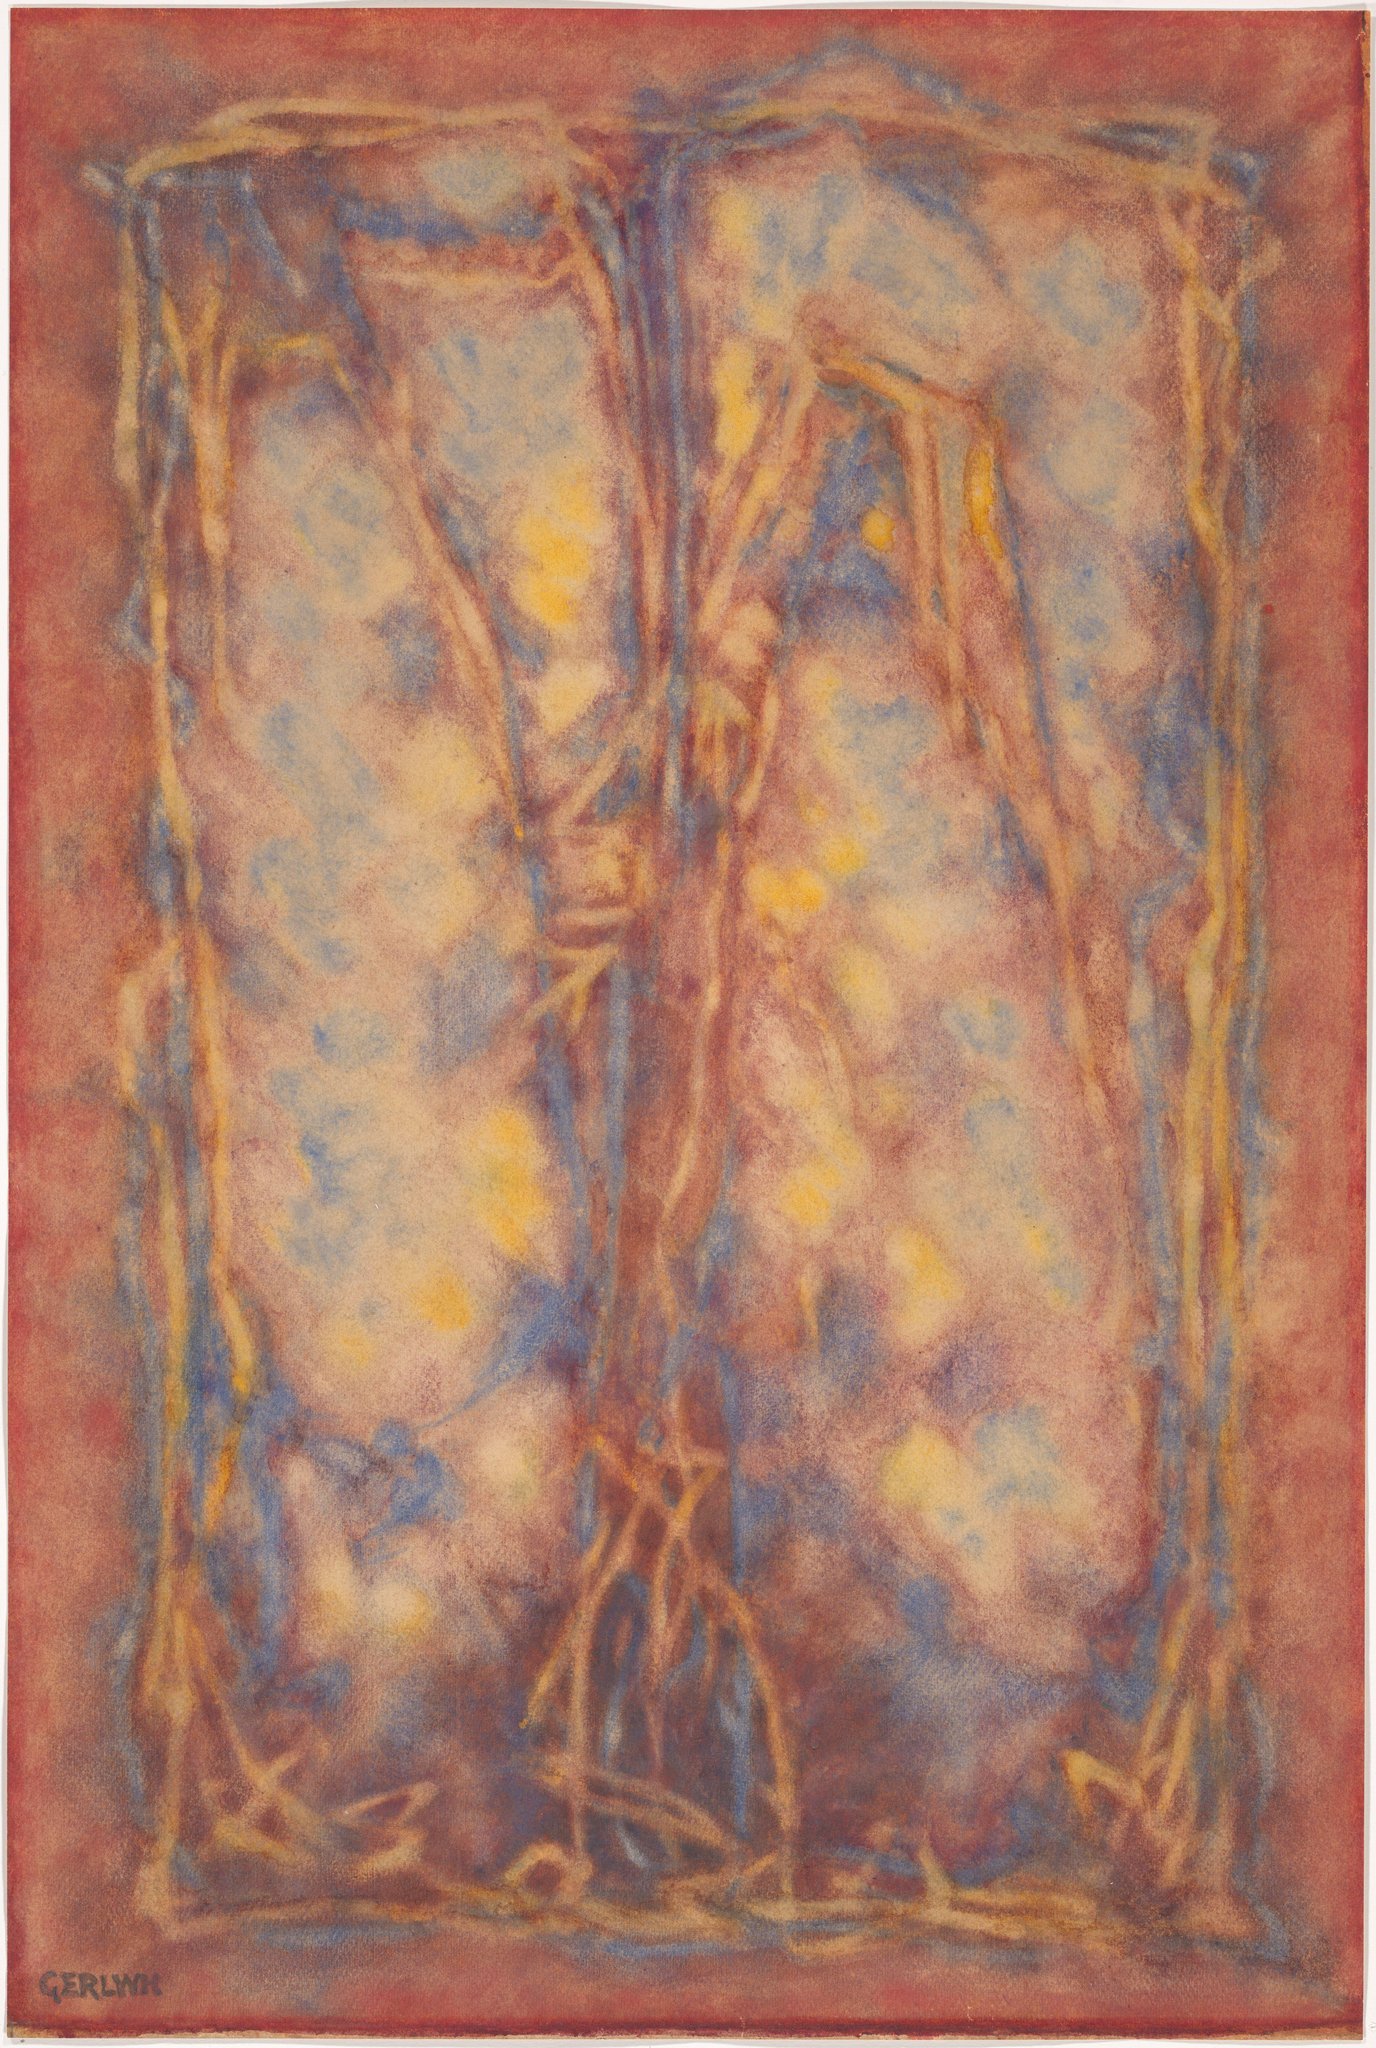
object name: drawing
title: Desire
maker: ger ladage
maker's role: print maker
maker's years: 1878-1932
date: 1917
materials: paper, watercolor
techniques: brush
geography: netherlands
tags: abstract, non-representational art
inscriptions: signature: ‘GERLWH’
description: Ger Ladage, or Gerlwh as he signed his name, was a theosophist who believed in the presence of an astral body (also called a soul body). This semi-transparent, spiritualised form around a person also appeared in images at the time. The contrasting colours, the transparent blow molds and the jerky contours in this watercolour evoke such an aura. In addition, there may be influences from Gerlwh’s profession as a decorator and stained-glass designer.